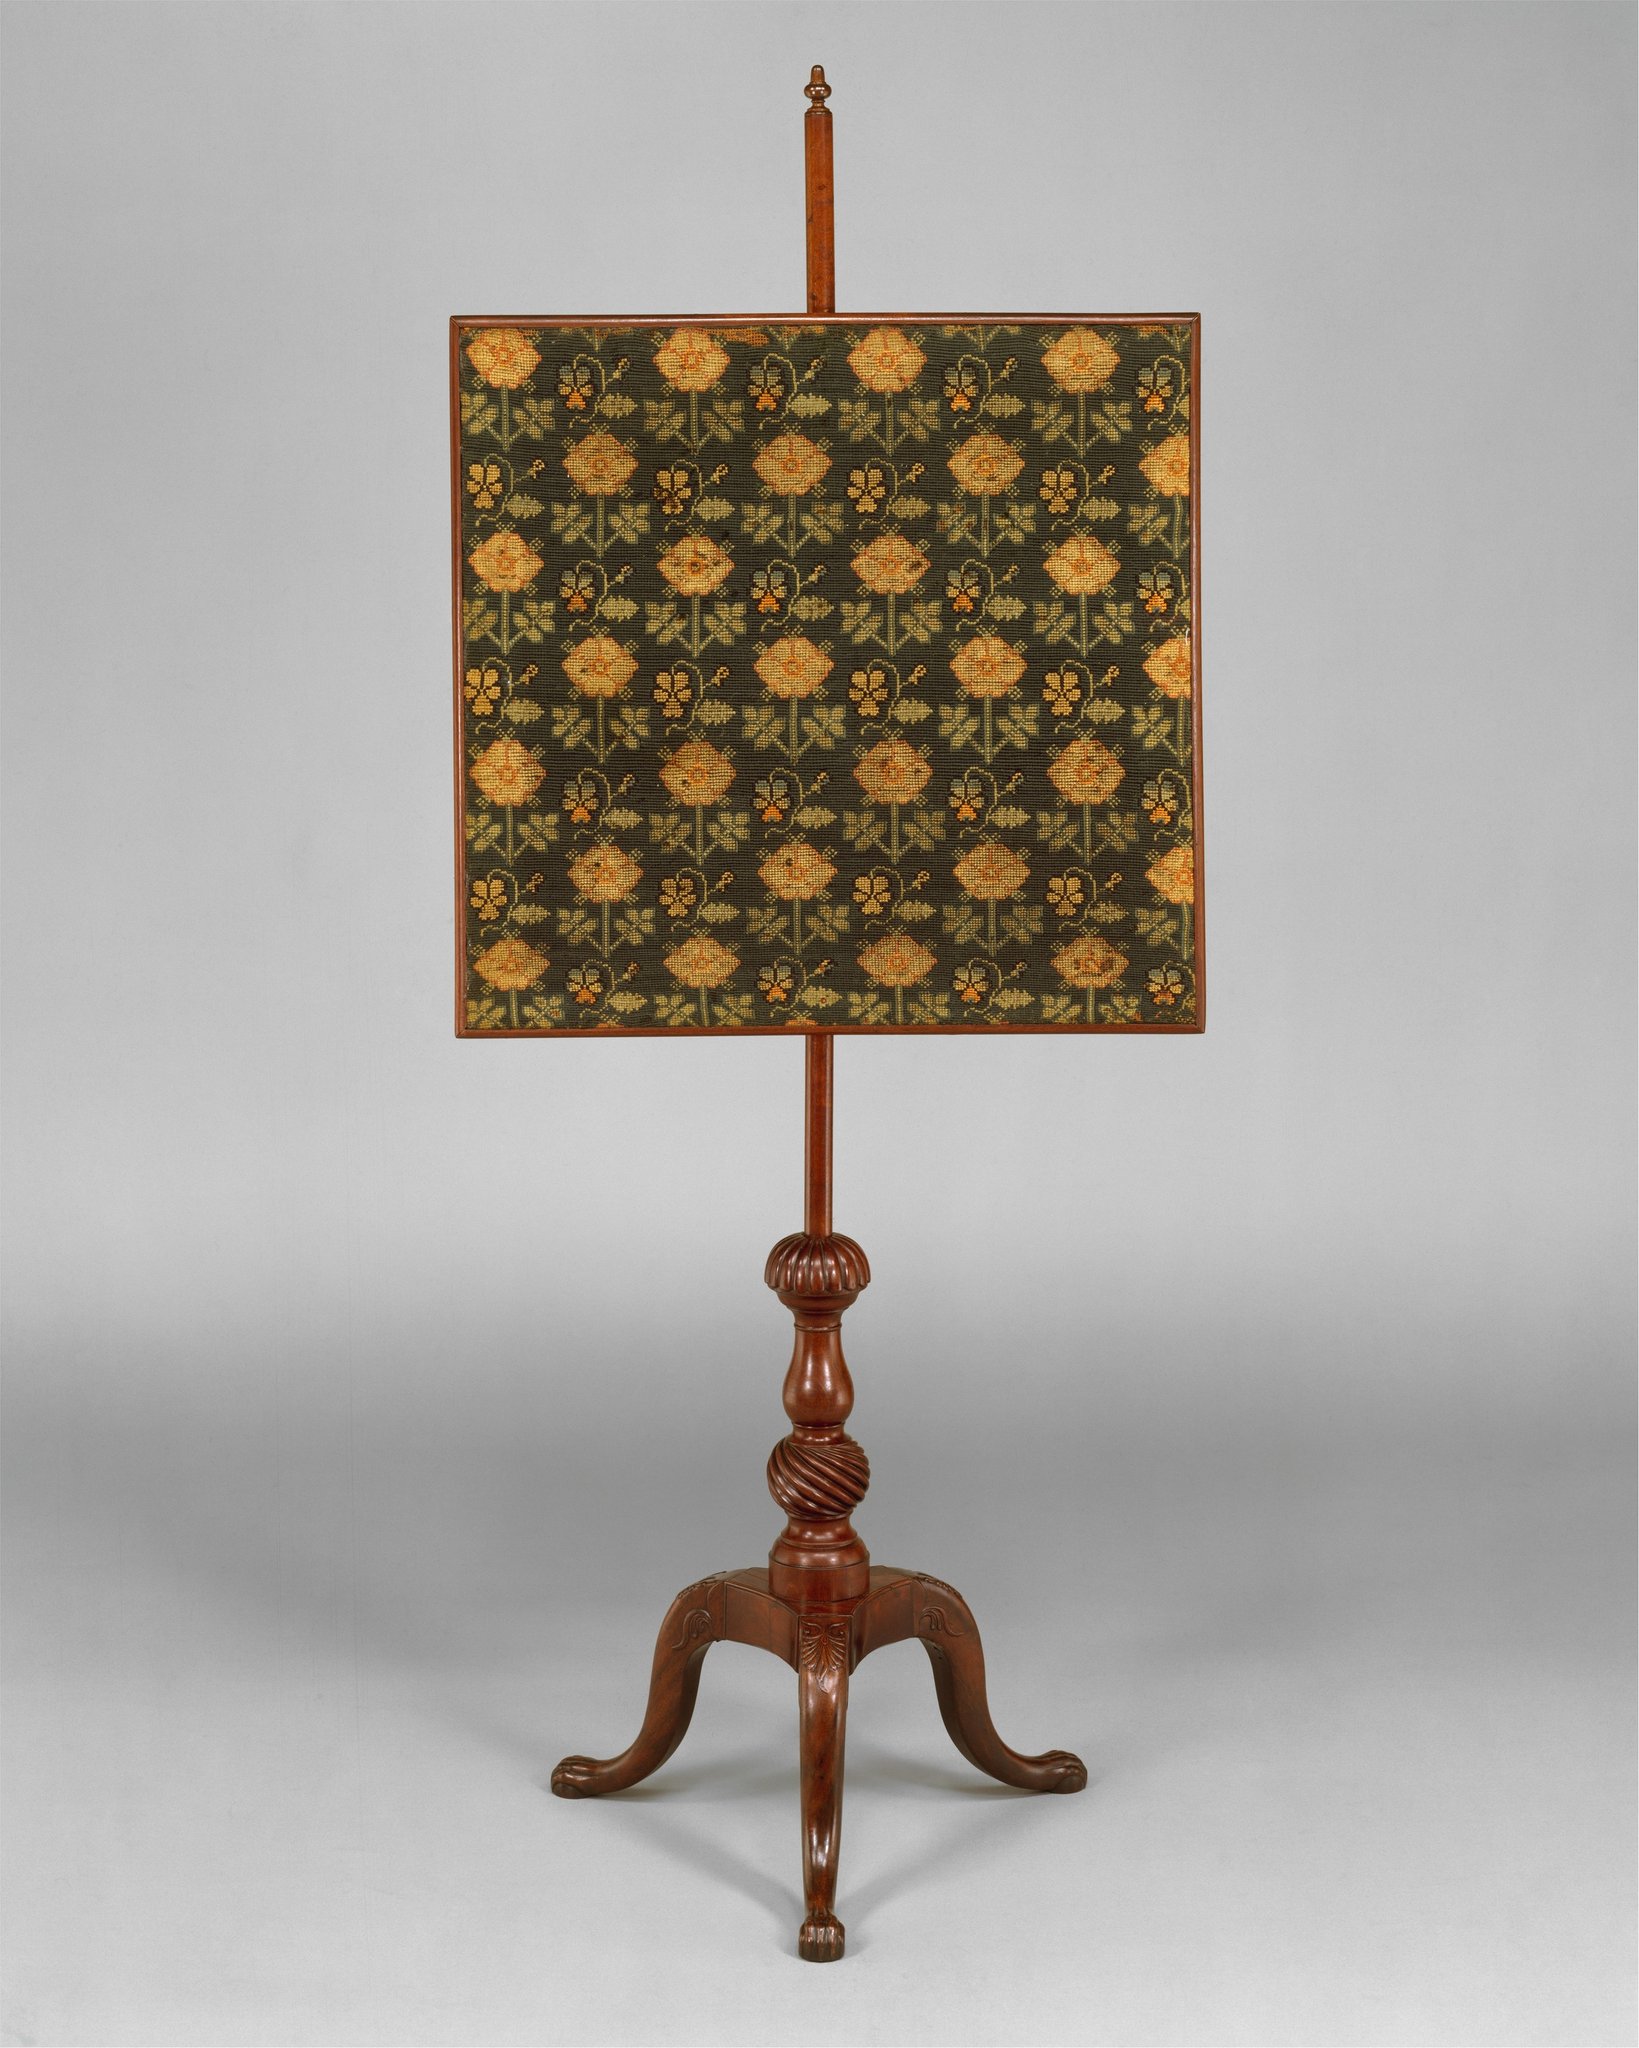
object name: firescreen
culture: american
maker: john townsend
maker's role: maker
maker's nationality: american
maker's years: 1732-1809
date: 1760-1790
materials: wood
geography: united states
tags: flowers